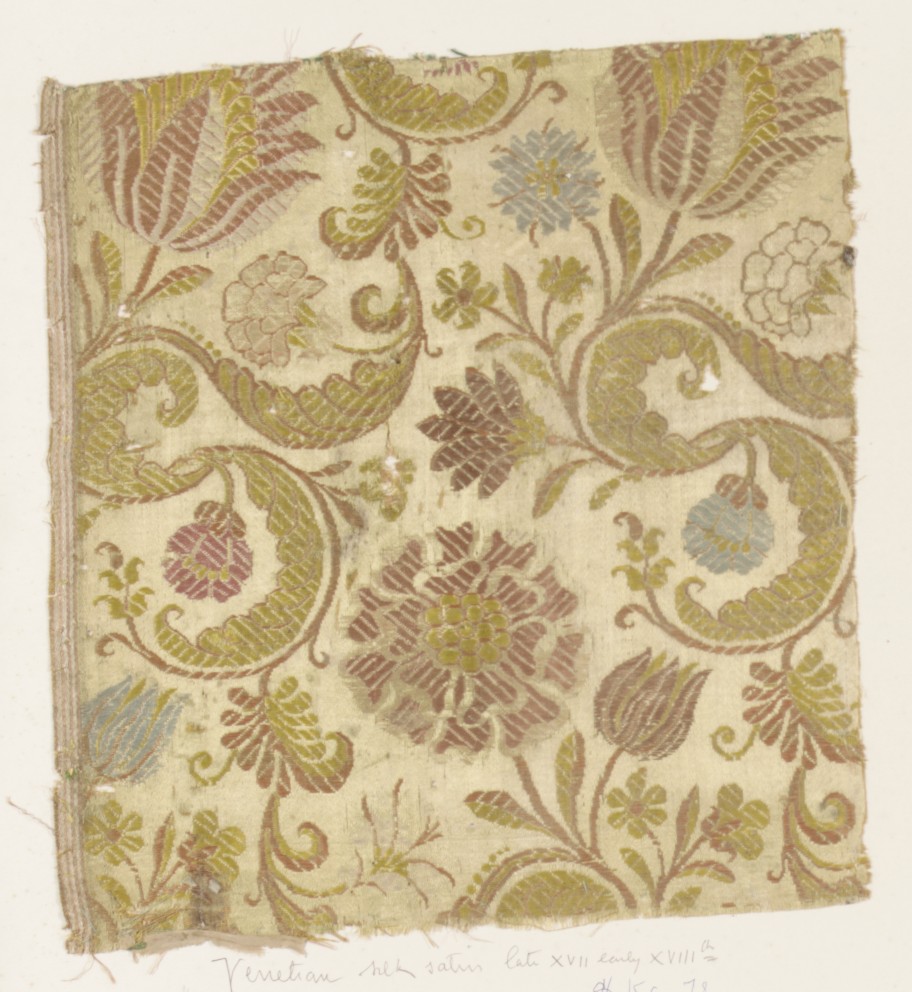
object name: fragment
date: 1701-1733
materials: silk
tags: flowers,leaves